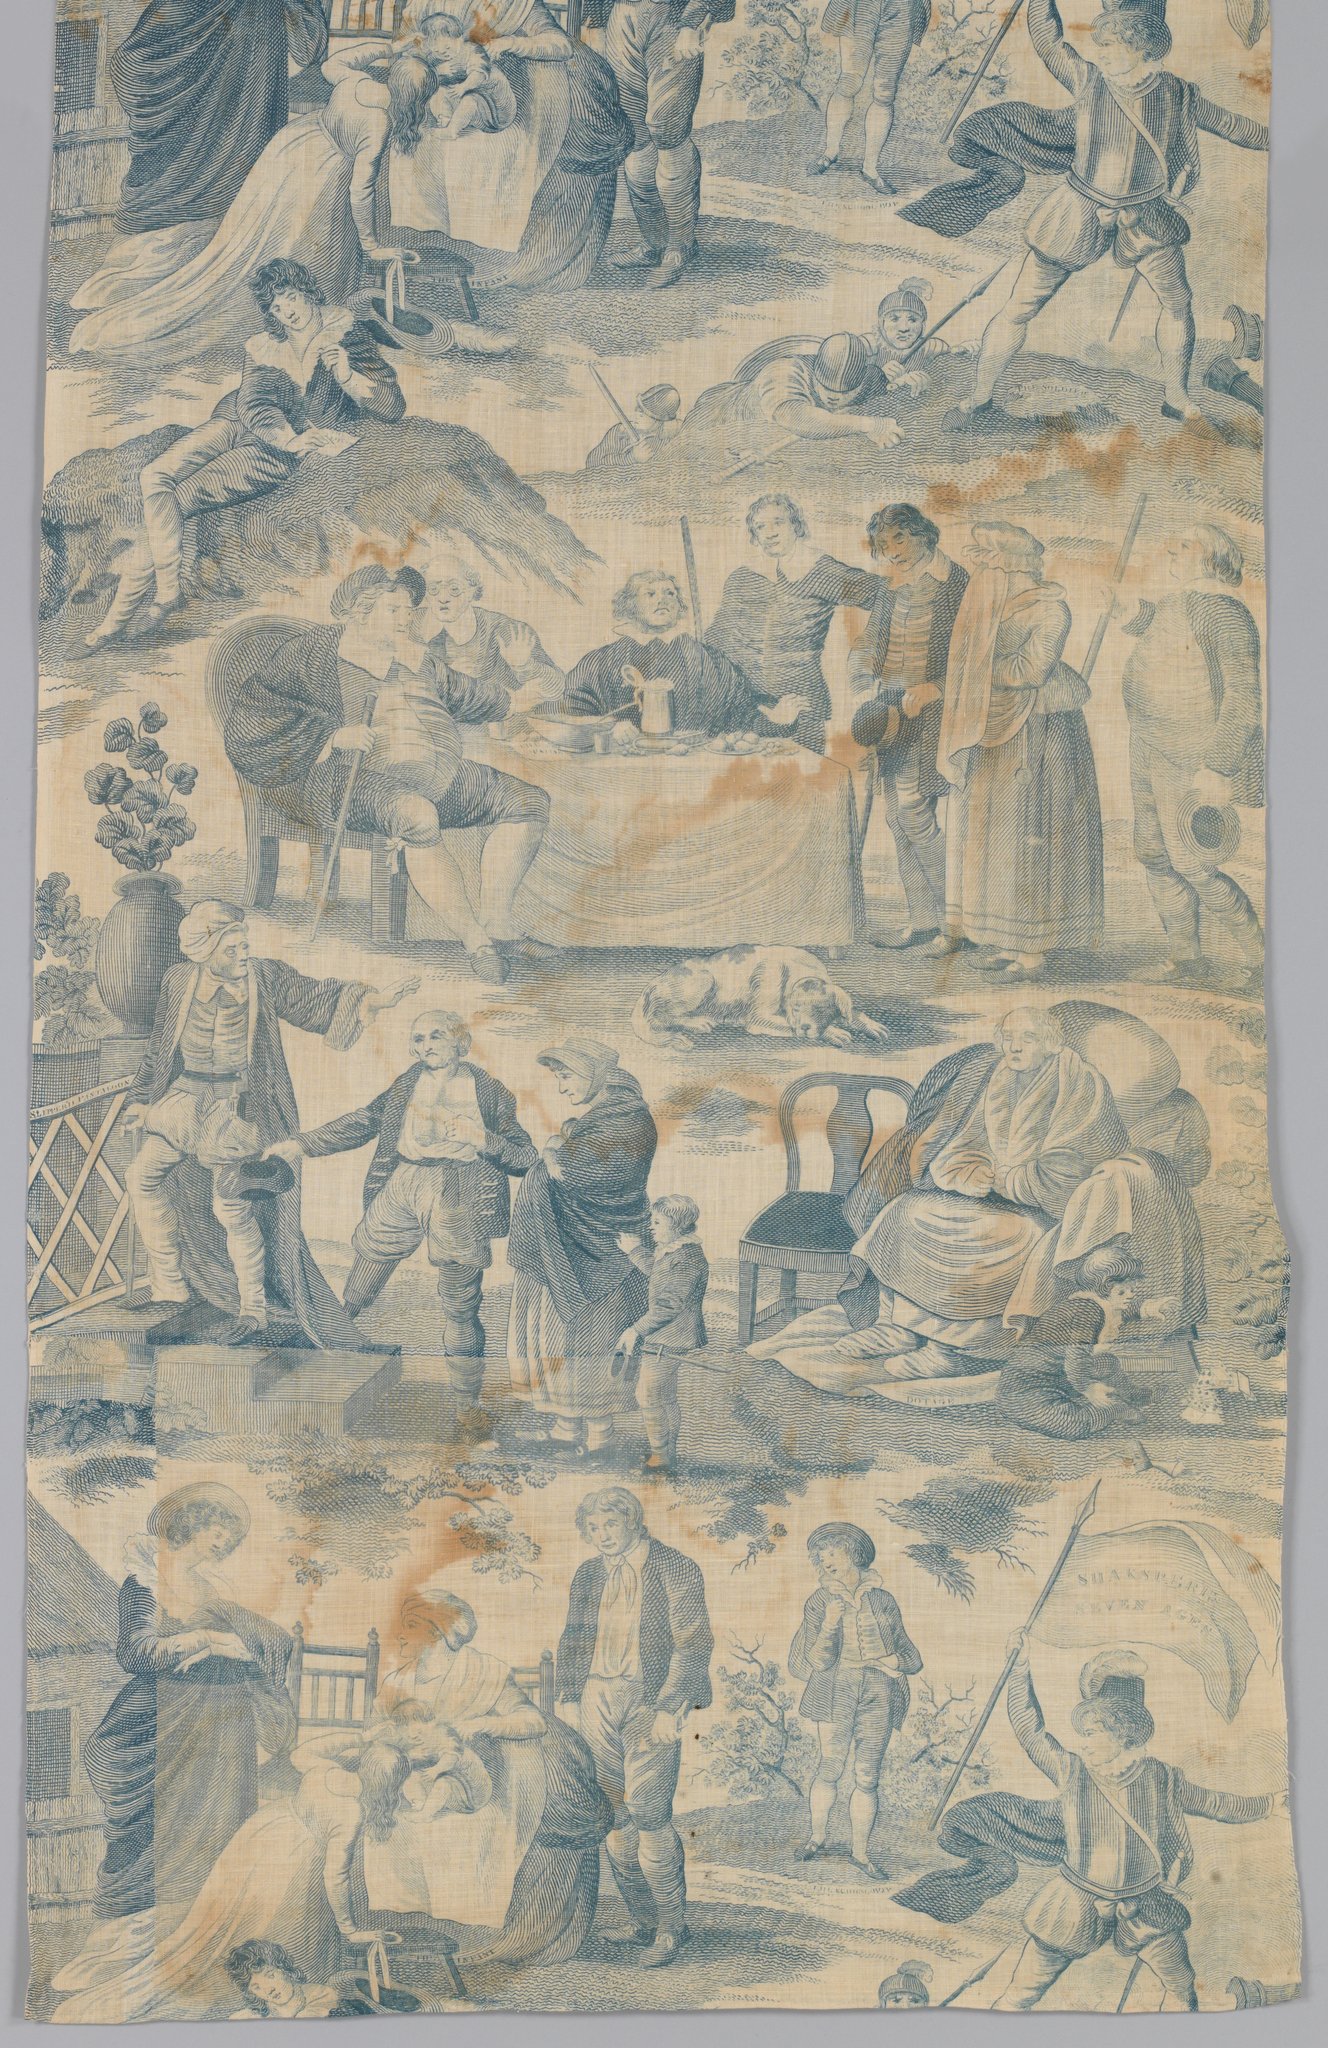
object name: piece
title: Shakespeare's "Seven Ages of Man"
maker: john slack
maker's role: engraver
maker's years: 1775-1875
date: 1805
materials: cotton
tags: shakespeare,boys,men,women,dogs